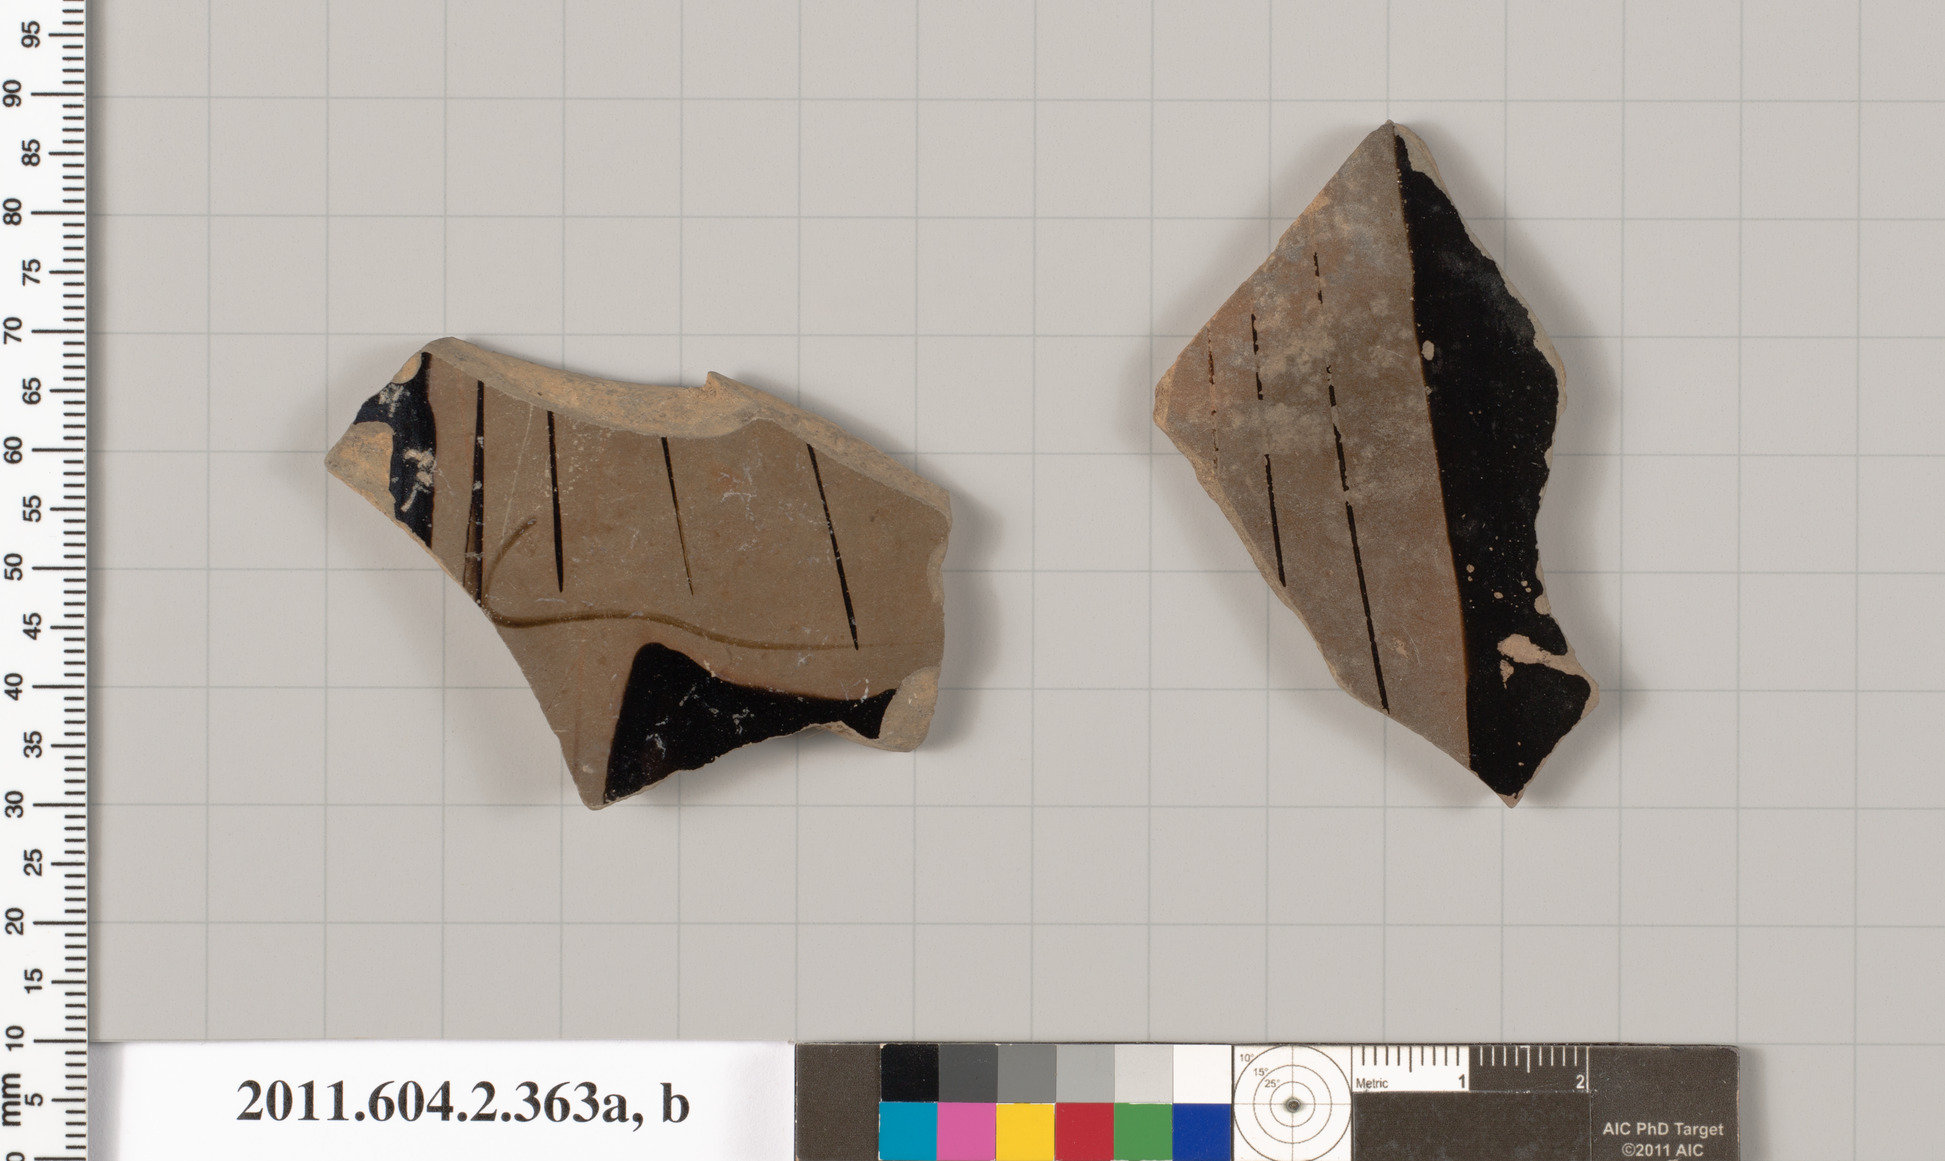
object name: column krater fragment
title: Terracotta fragments of a column-krater (bowl for mixing wine and water)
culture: greek, attic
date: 450-430 BCE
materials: terracotta